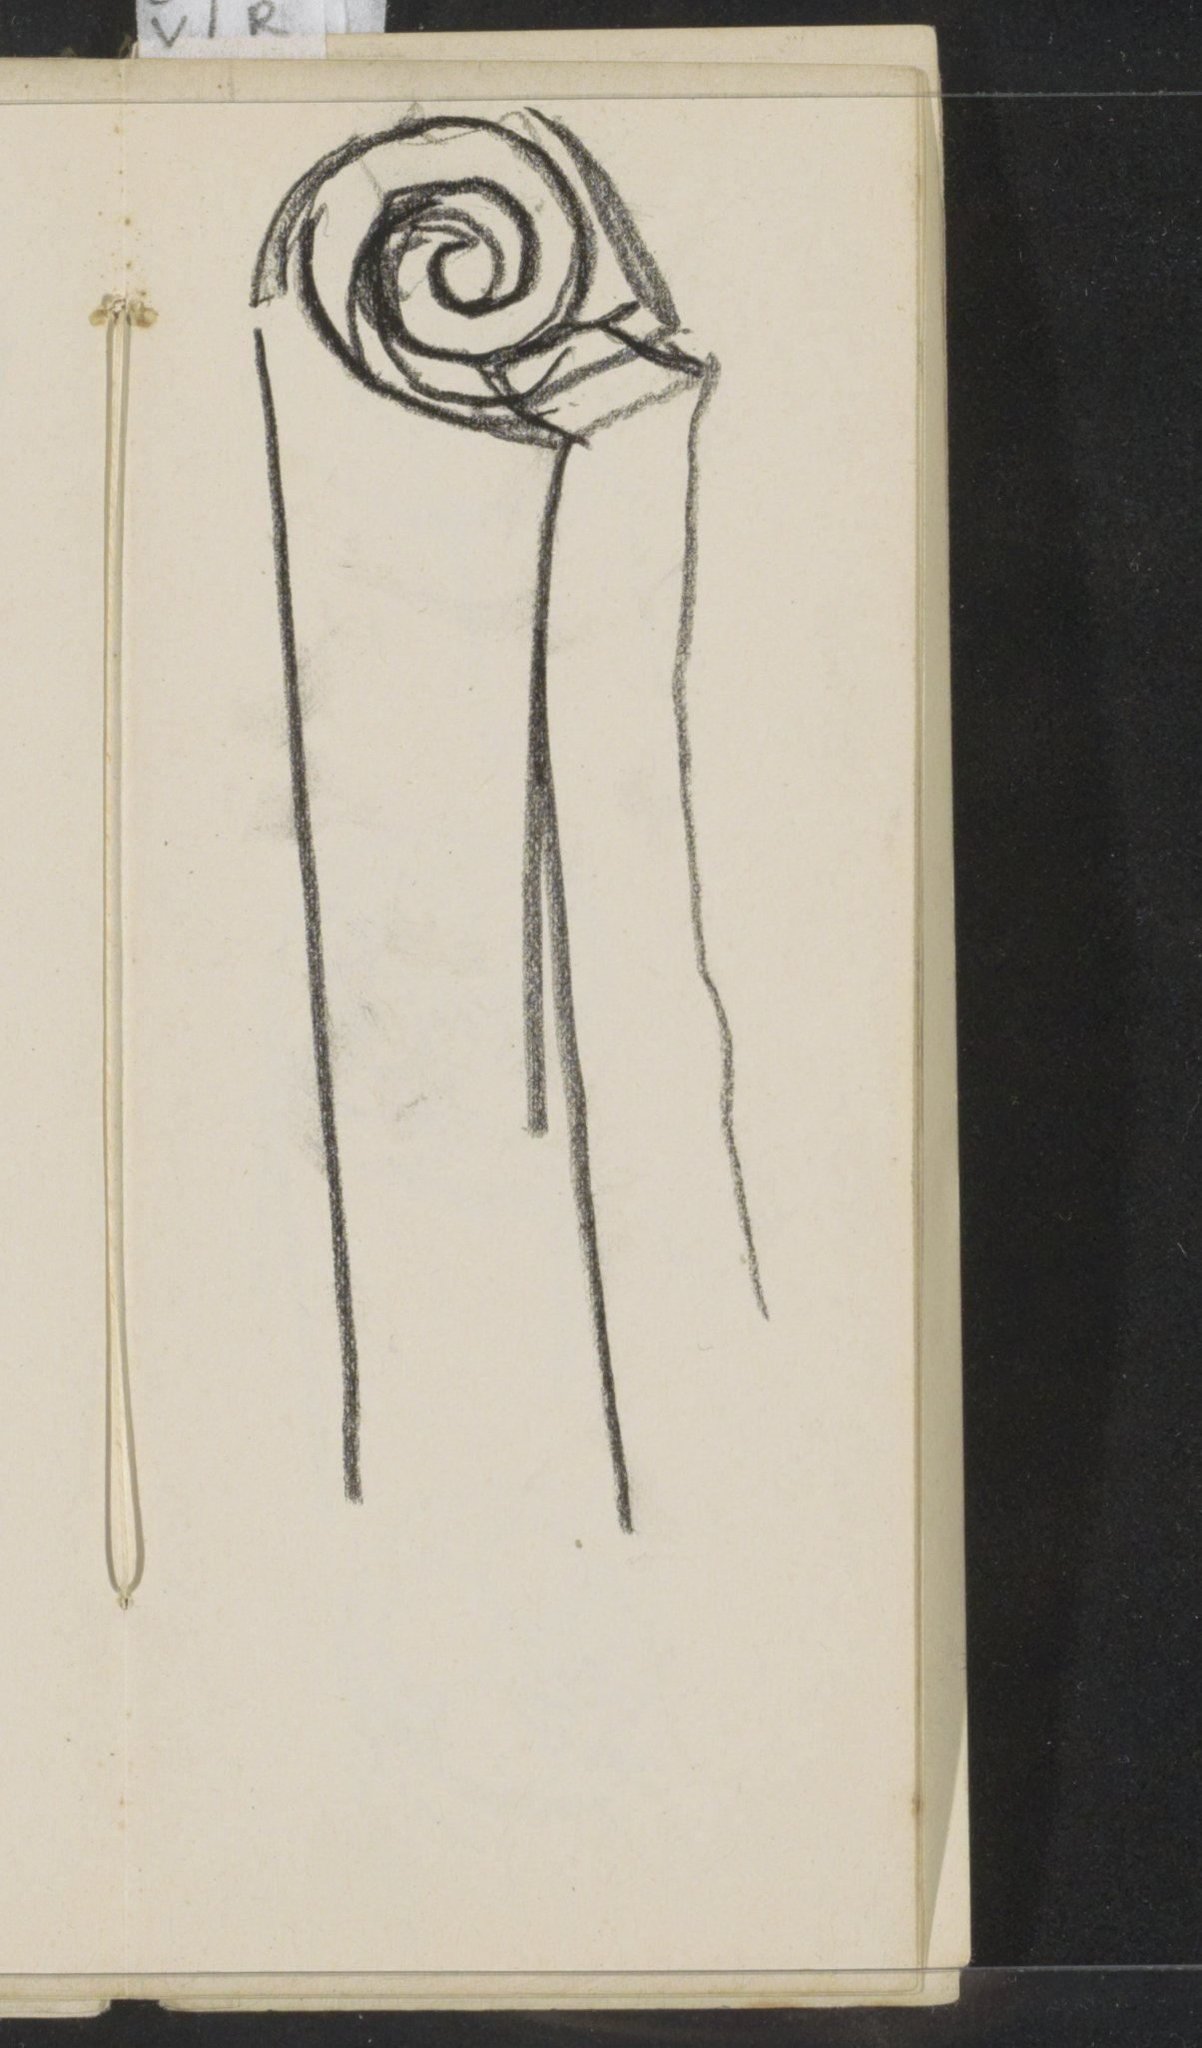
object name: sketchbook leaf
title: Ornament met rolwerk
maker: gerrit willem dijsselhof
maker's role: designer, draughtsman, print maker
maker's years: 1866-1924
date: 1901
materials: chalk, paper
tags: ornaments ~ art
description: Blad 9 recto uit een schetsboek met 42 bladzijden.